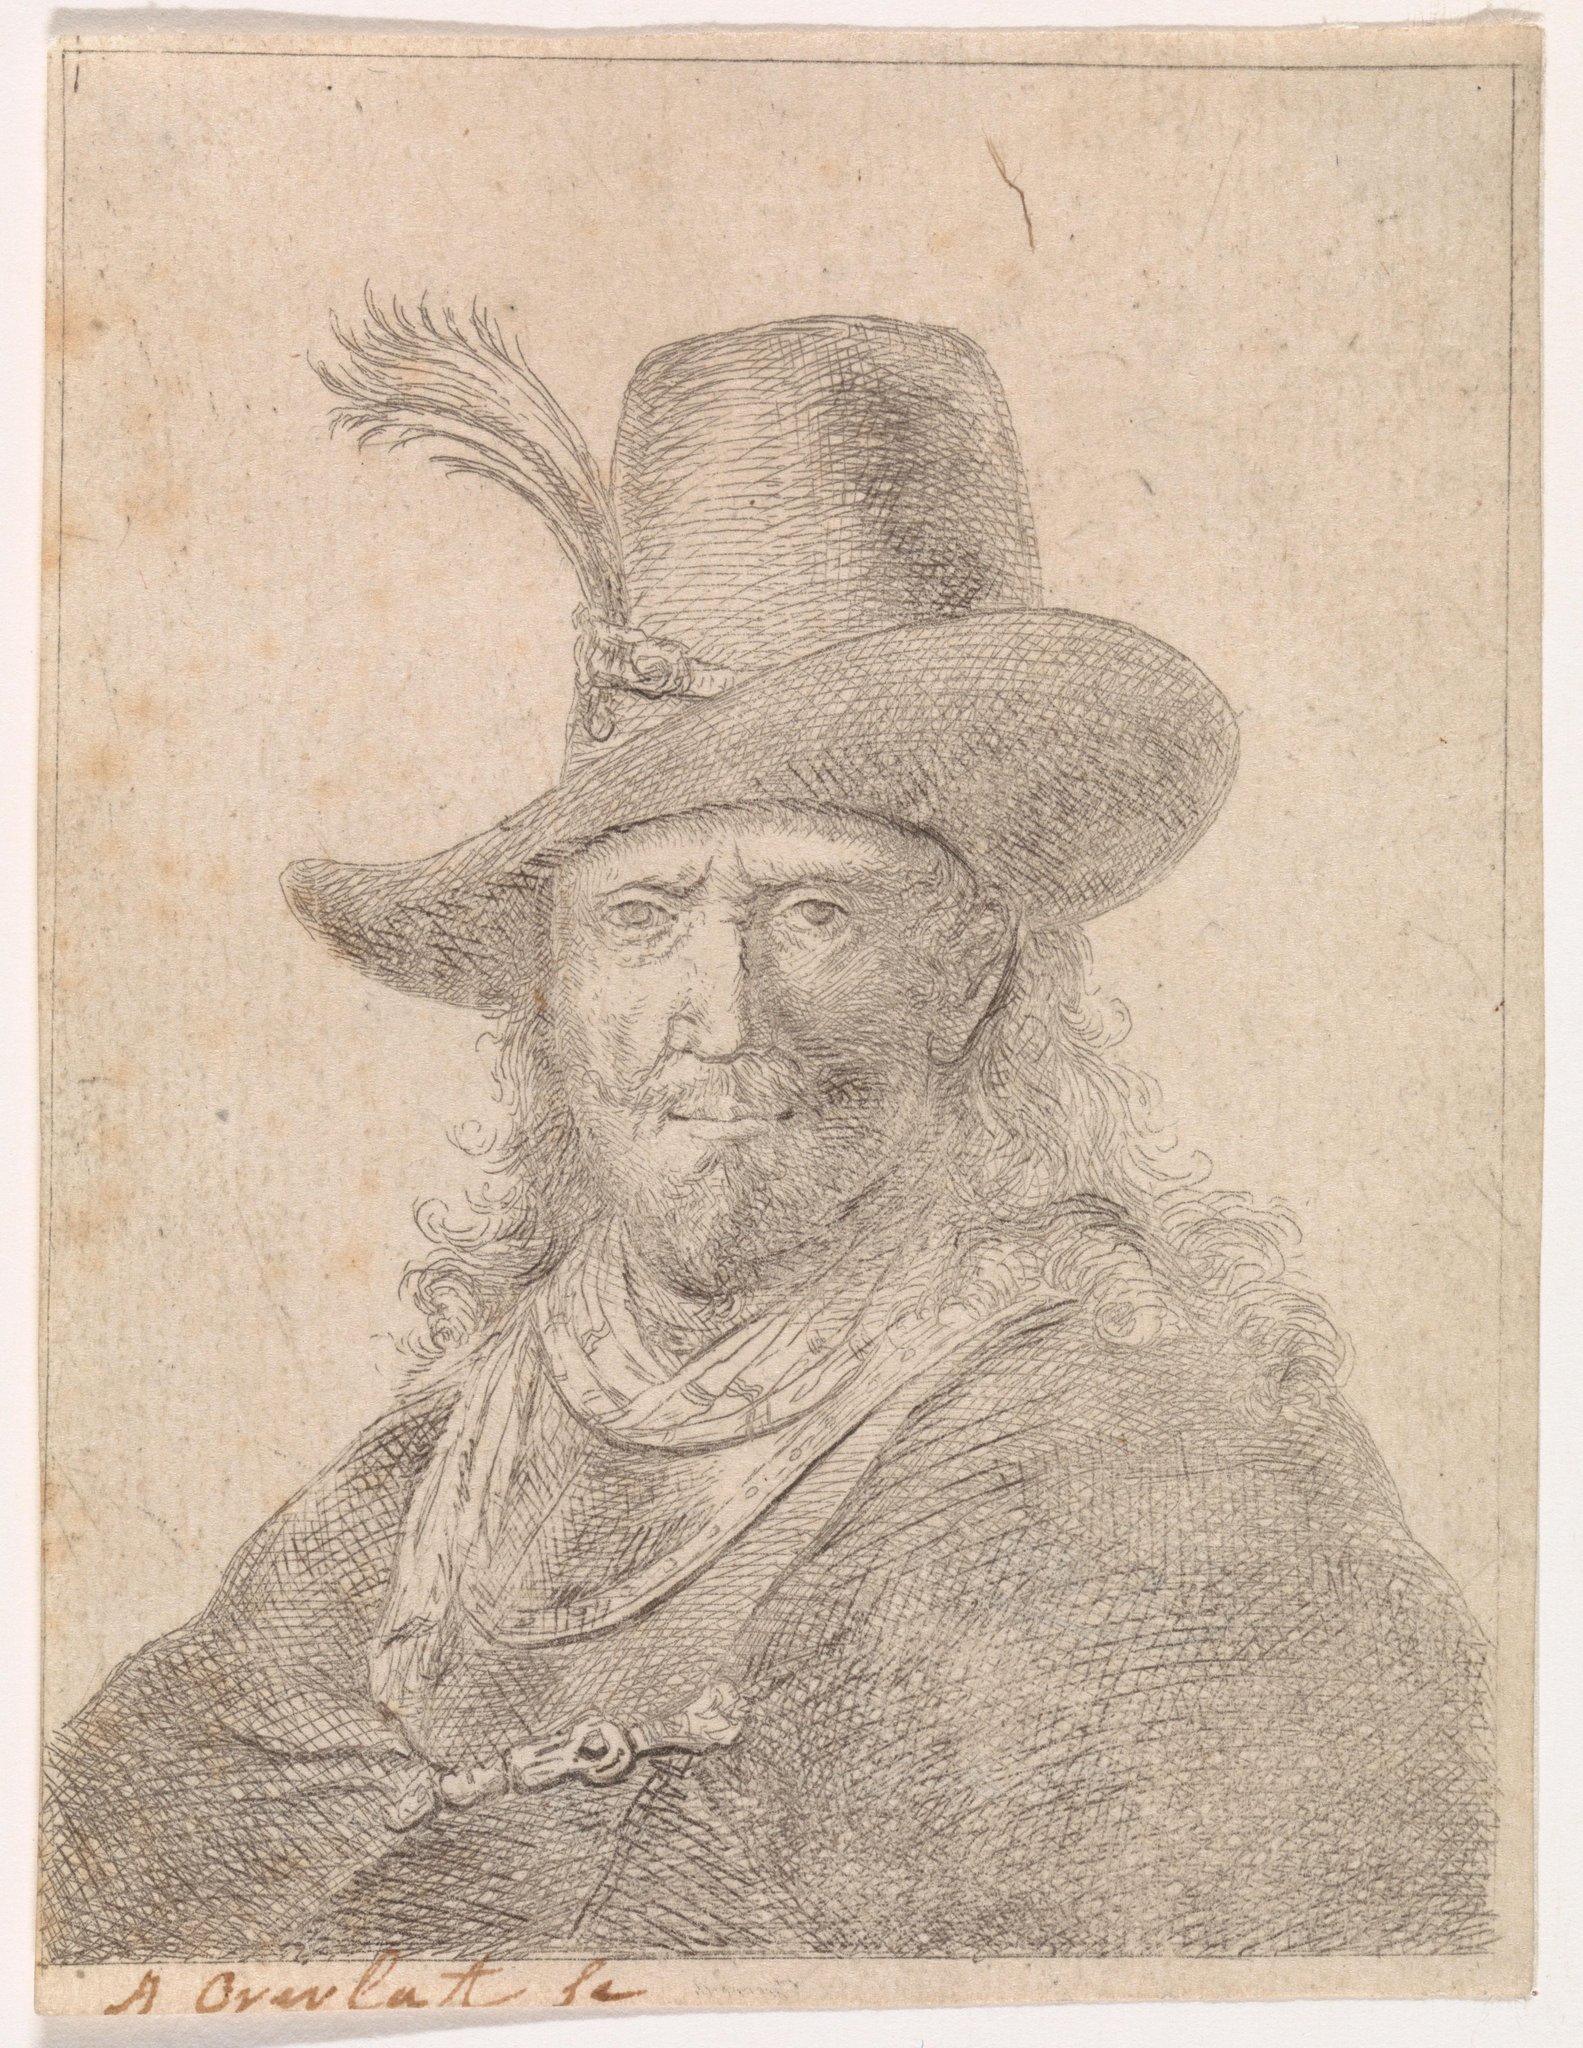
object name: print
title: Buste van een man met hoed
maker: antoon overlaet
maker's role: draughtsman, print maker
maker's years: 1720-1774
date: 1760-1774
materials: paper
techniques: engraving, etching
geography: antwerp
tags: anonymous historical person portrayed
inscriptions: collector's mark: Lugt 2228